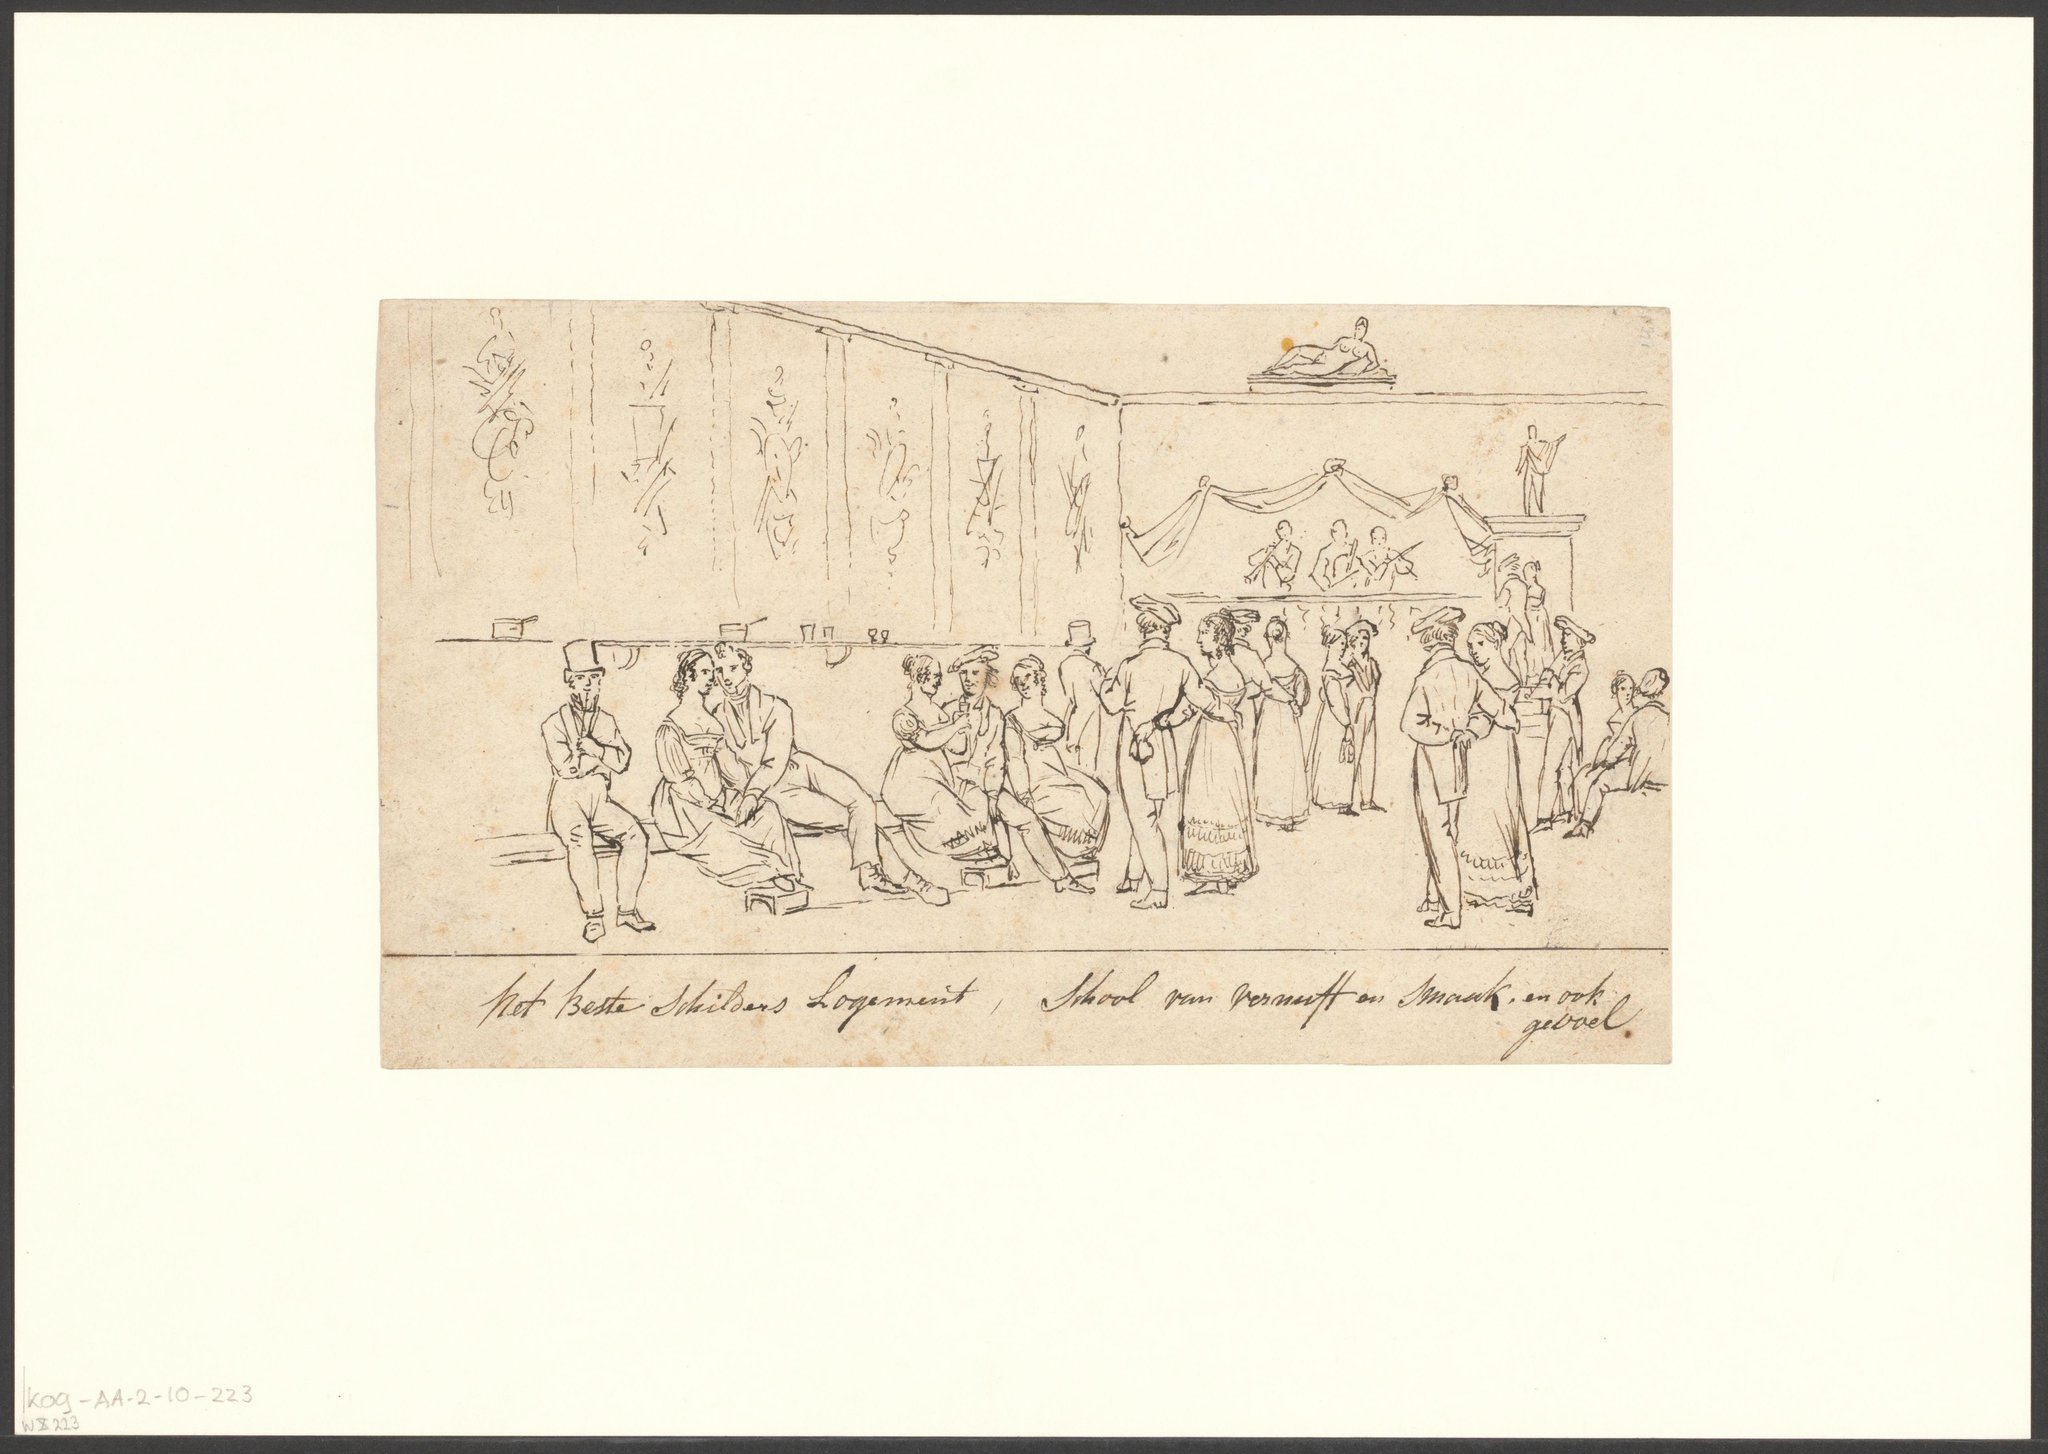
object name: drawing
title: Socialiserende mannen en vrouwen in een dansruimte, mogelijk het interieur van muziek- en speelhuis De Pijl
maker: Anonymous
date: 1800-1899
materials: ink, paper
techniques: pen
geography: amsterdam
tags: brothel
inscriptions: collector's mark: Lugt 800a, inscription: ‘Het Beste Schilders Logement, School van vernuft en smaak, en ook / gevoel’, stamp: ‘J. van Eck’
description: Tekening binnen de Atlas Van Eck ingedeeld op wijknummer 10.